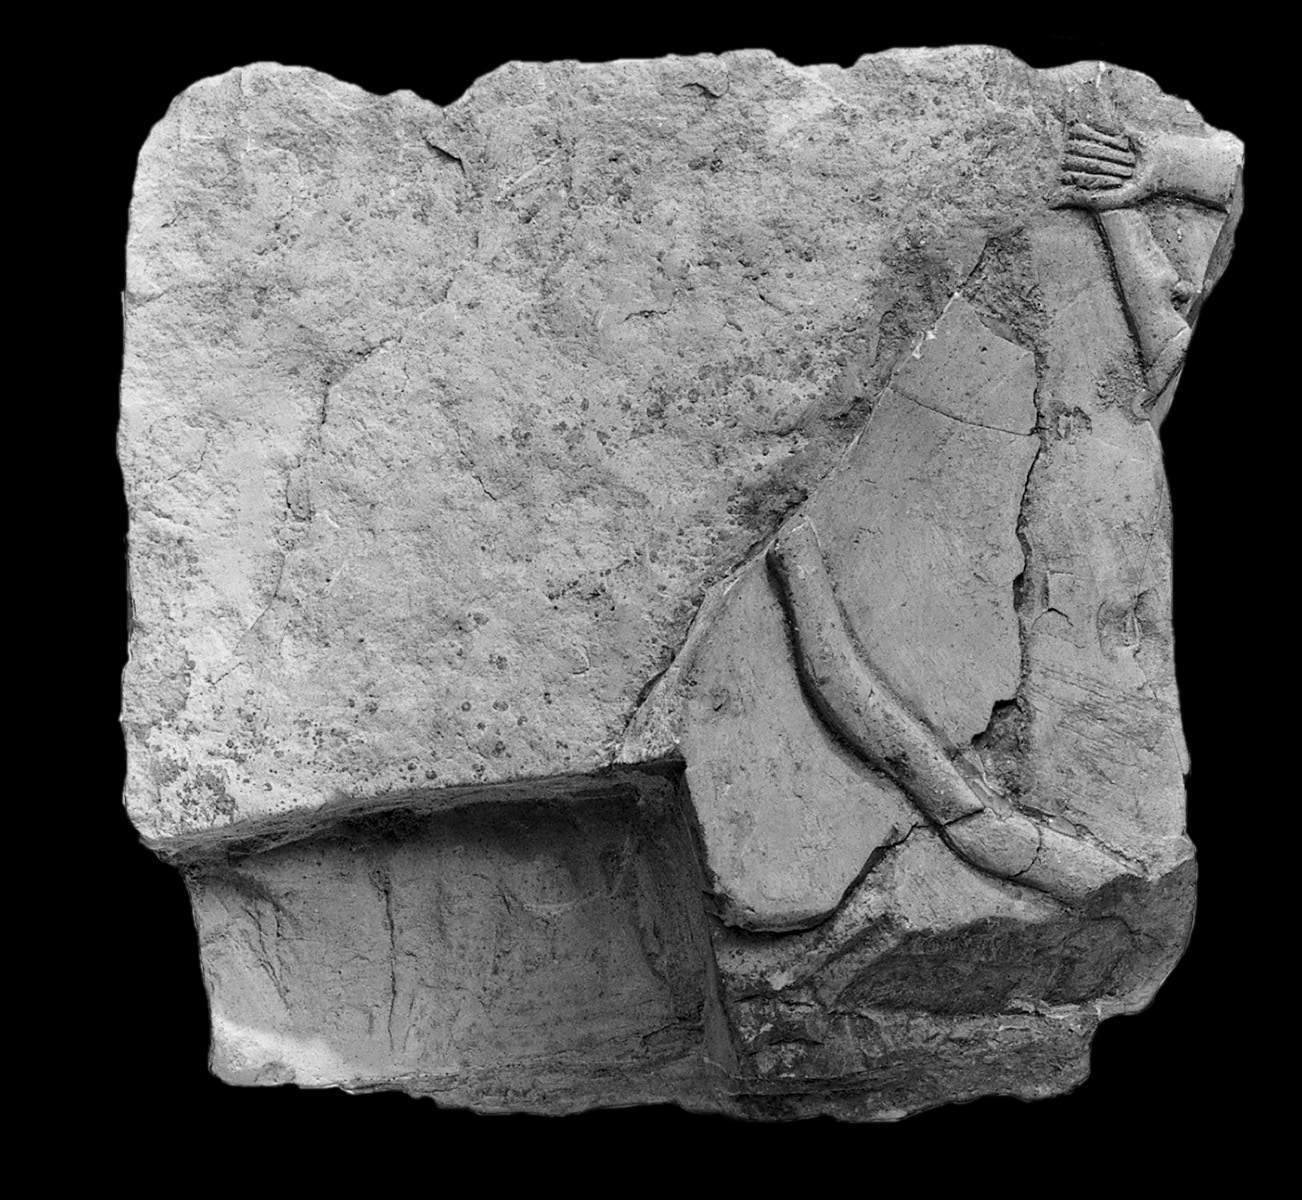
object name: relief, tomb of nespekashuty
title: Raised relief fragment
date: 664-610 BCE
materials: limestone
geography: egypt